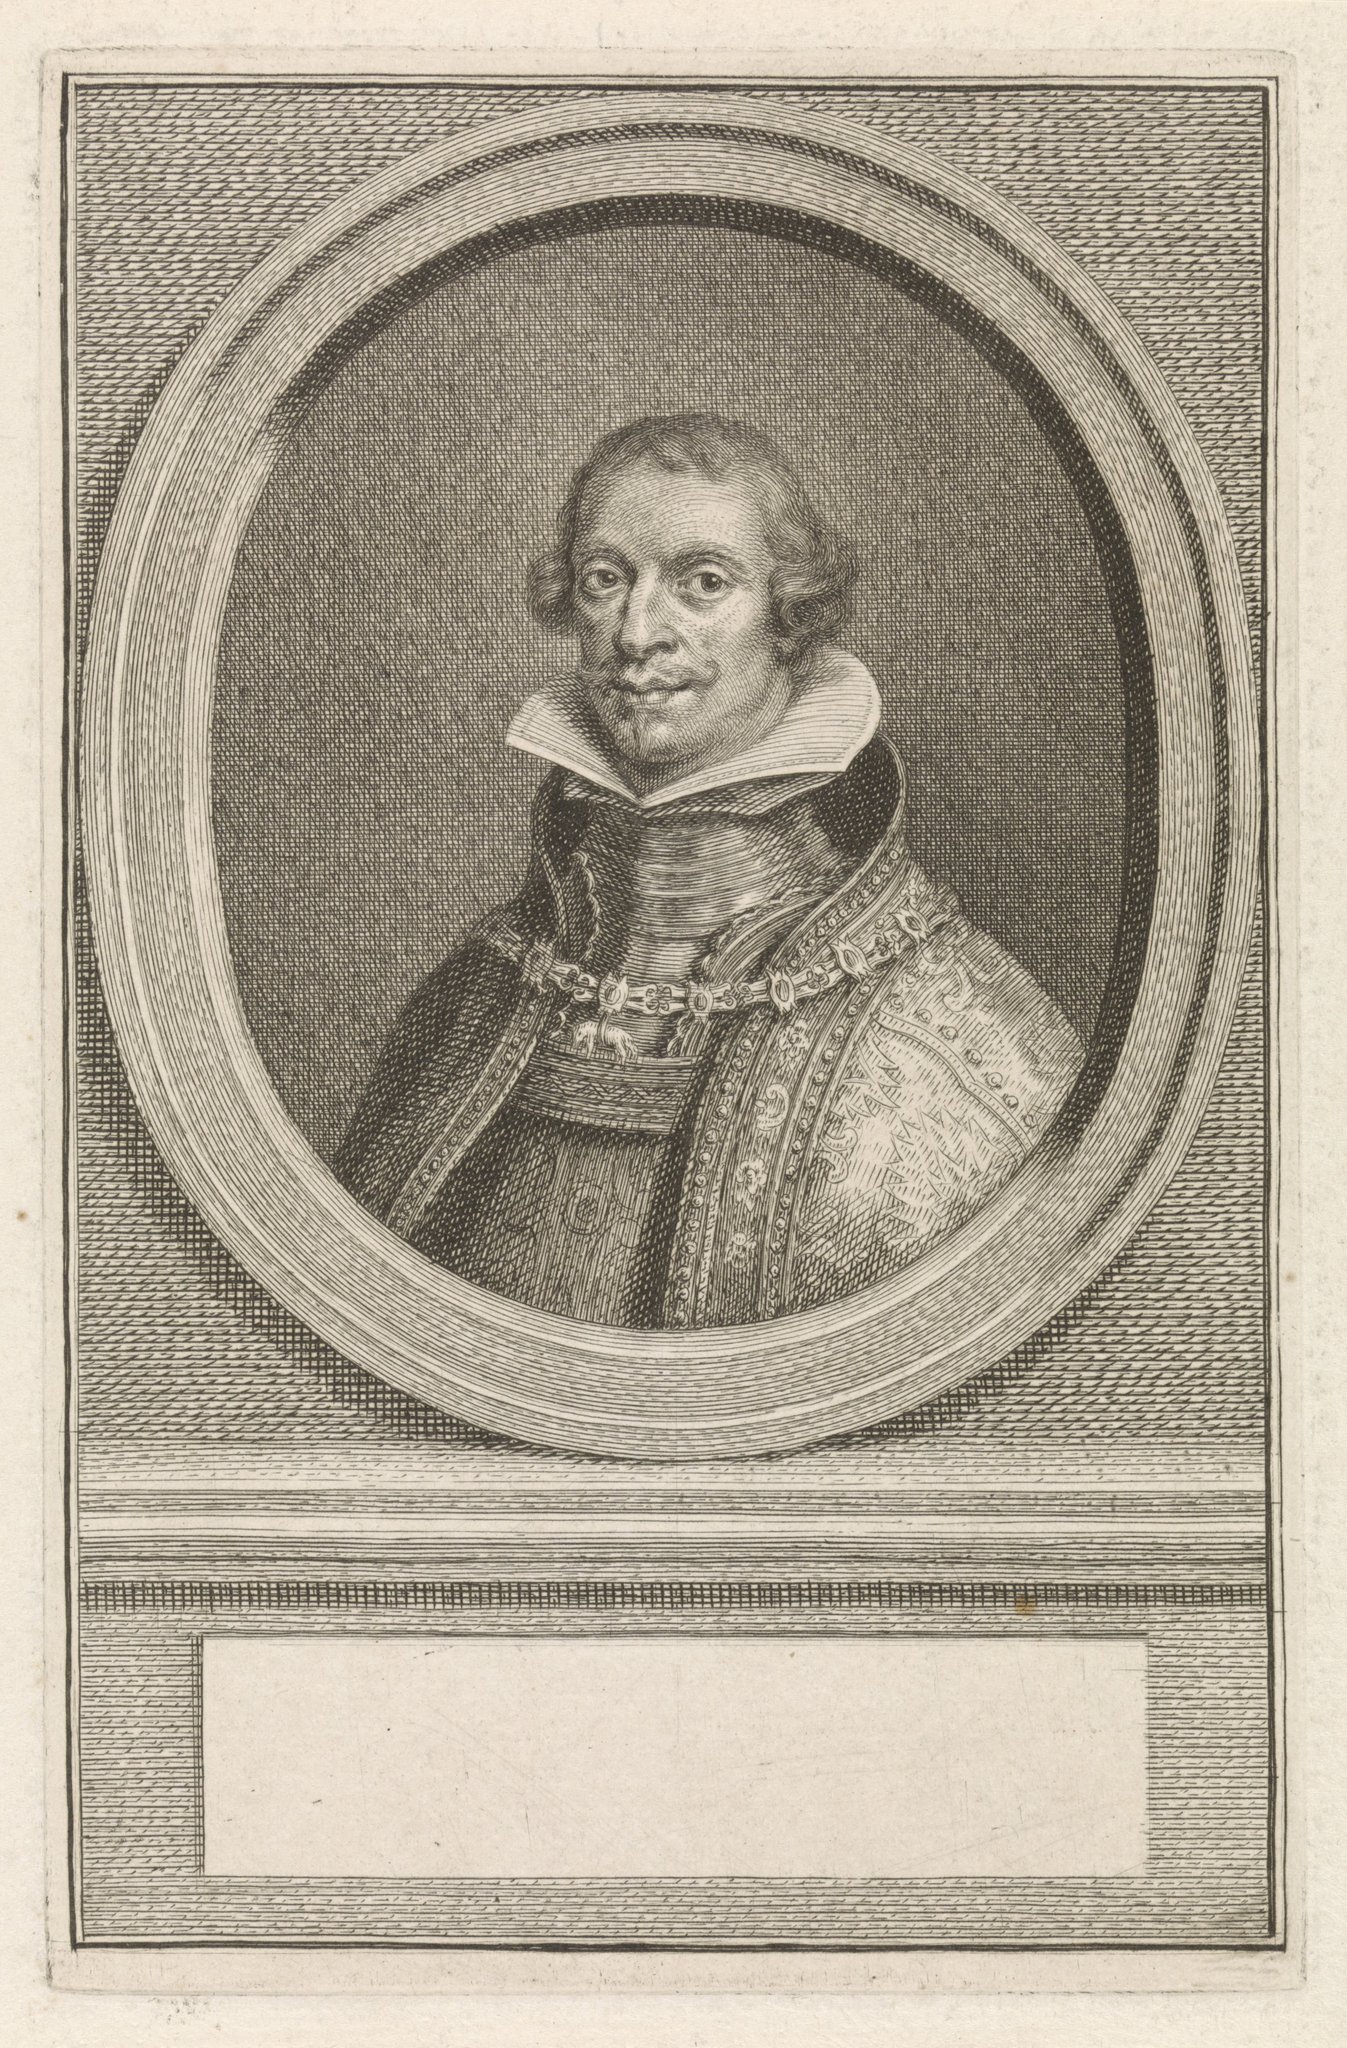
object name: print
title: Portret van Filips IV, koning van Spanje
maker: jacob houbraken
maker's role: draughtsman, print maker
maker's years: 1698-1780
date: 1747-1759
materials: paper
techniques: engraving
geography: amsterdam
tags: filips iv (koning van spanje)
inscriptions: collector's mark: Lugt 240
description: Prroefdruk van de prent gebruikt in: Jan Wagenaar, Vaderlandsche historie, vervattende de geschiedenissen der nu Vereenigde Nederlanden, inzonderheid die van Holland (...), 21 delen. Amsterdam, Johannes Allart, 1790-96.